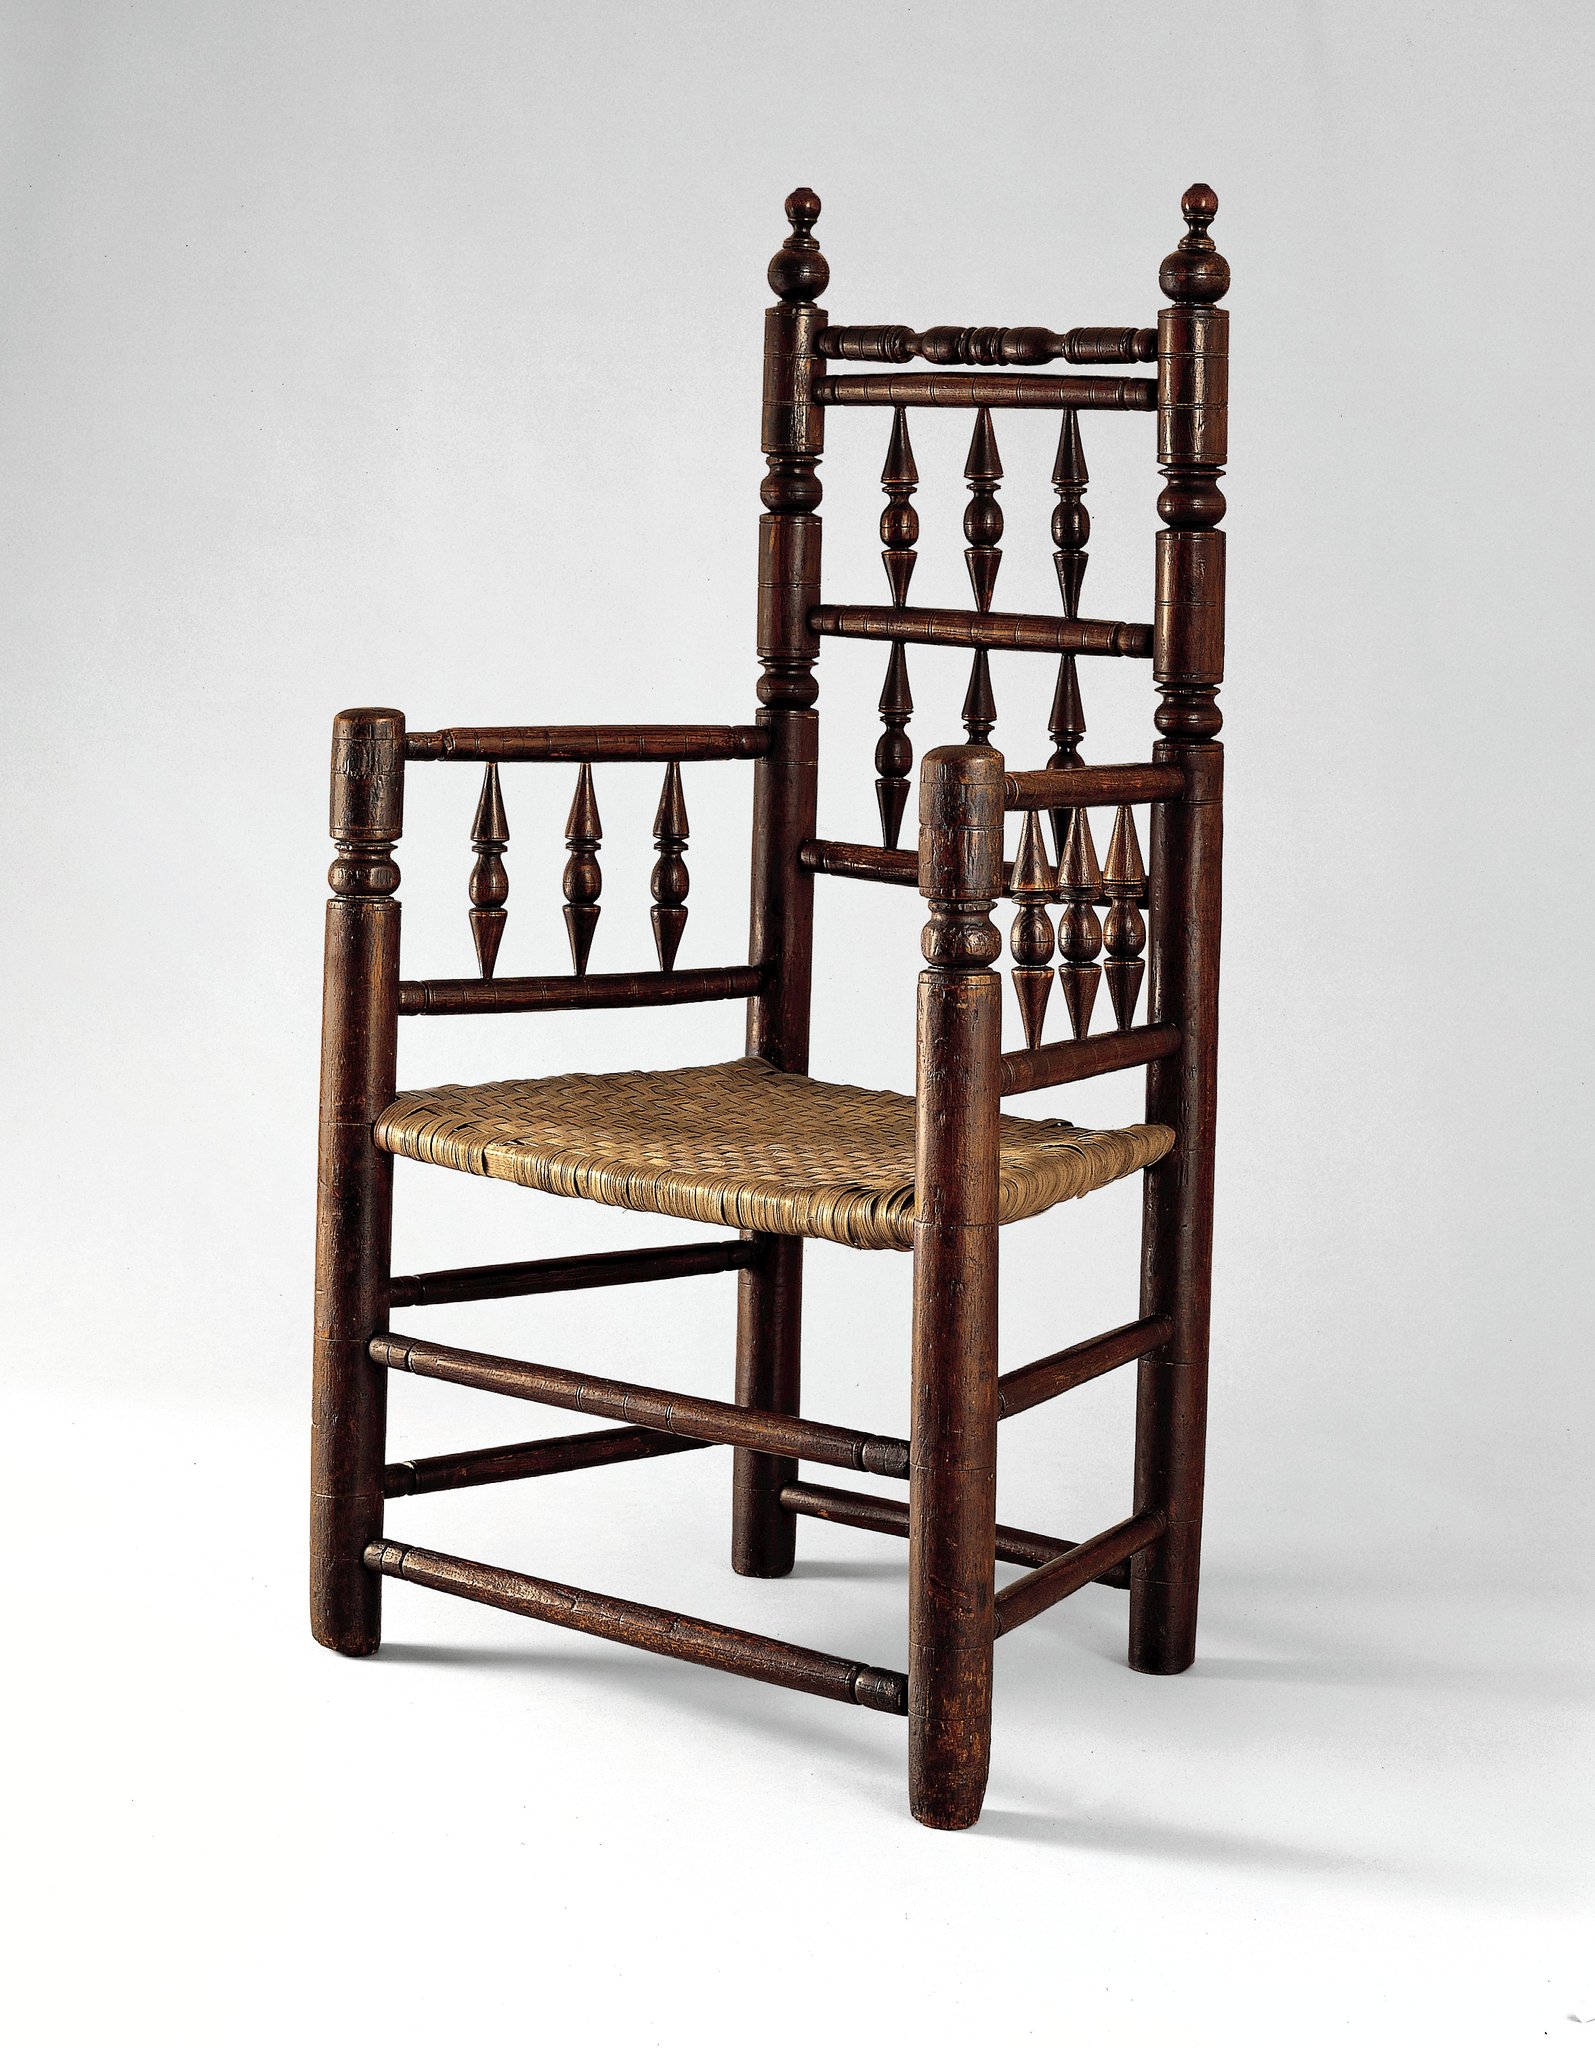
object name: armchair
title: Turned Armchair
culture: american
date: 1630-1700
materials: wood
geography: united states